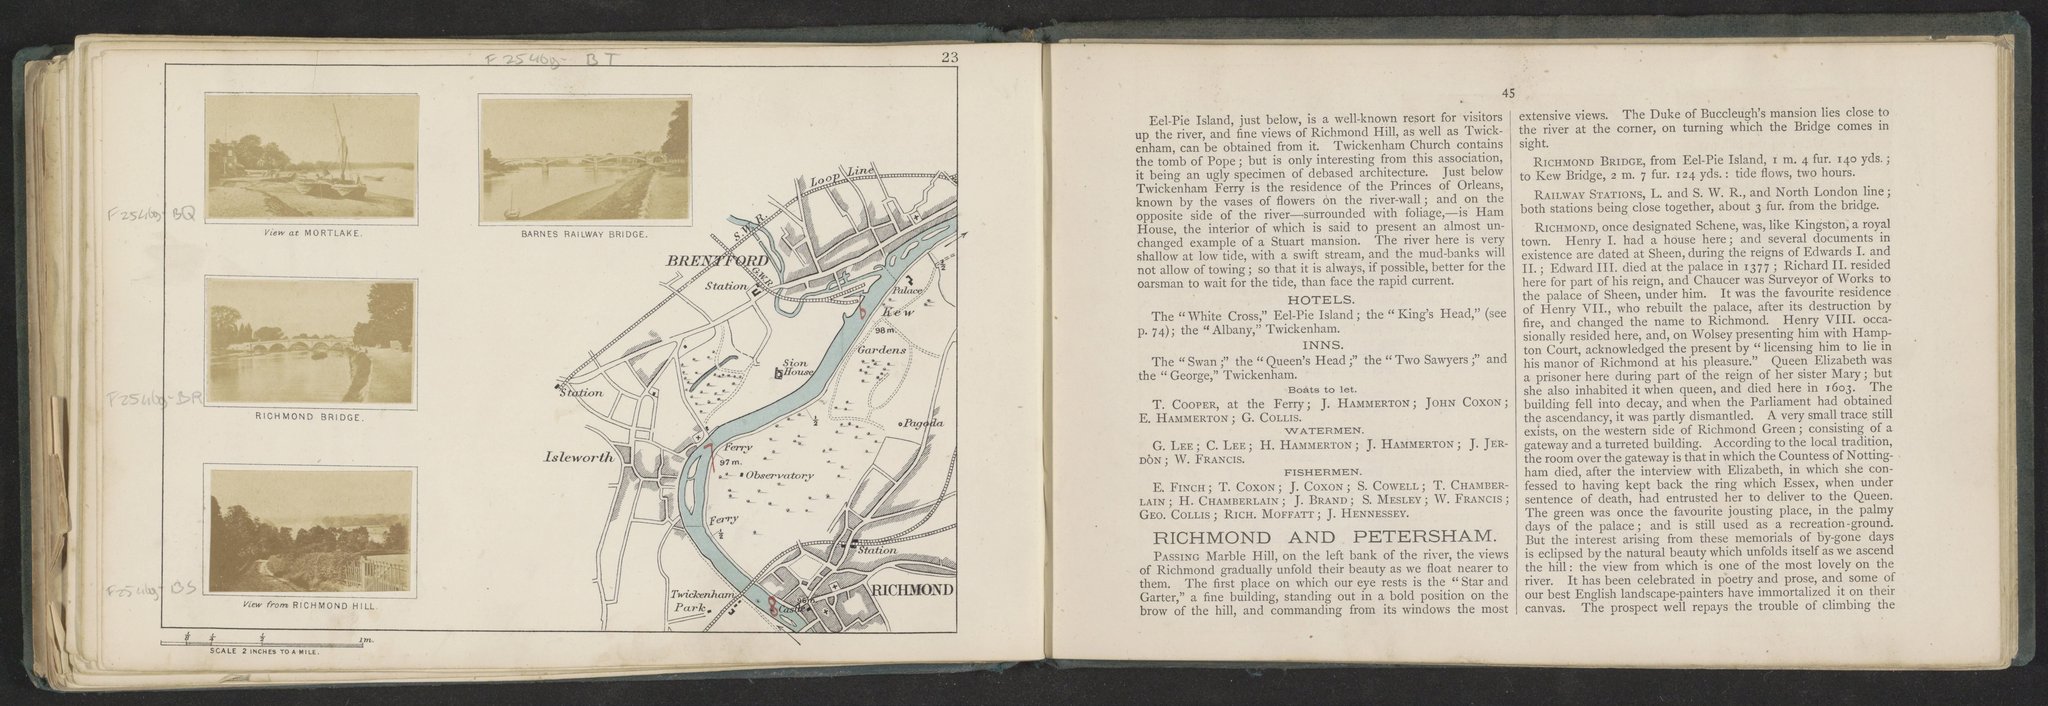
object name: photograph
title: Barnes railway bridge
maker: henry w. taunt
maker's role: fotograaf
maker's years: 1842-1922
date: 1871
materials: photographic support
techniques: albumen print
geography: barnes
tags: river, bridge, thames